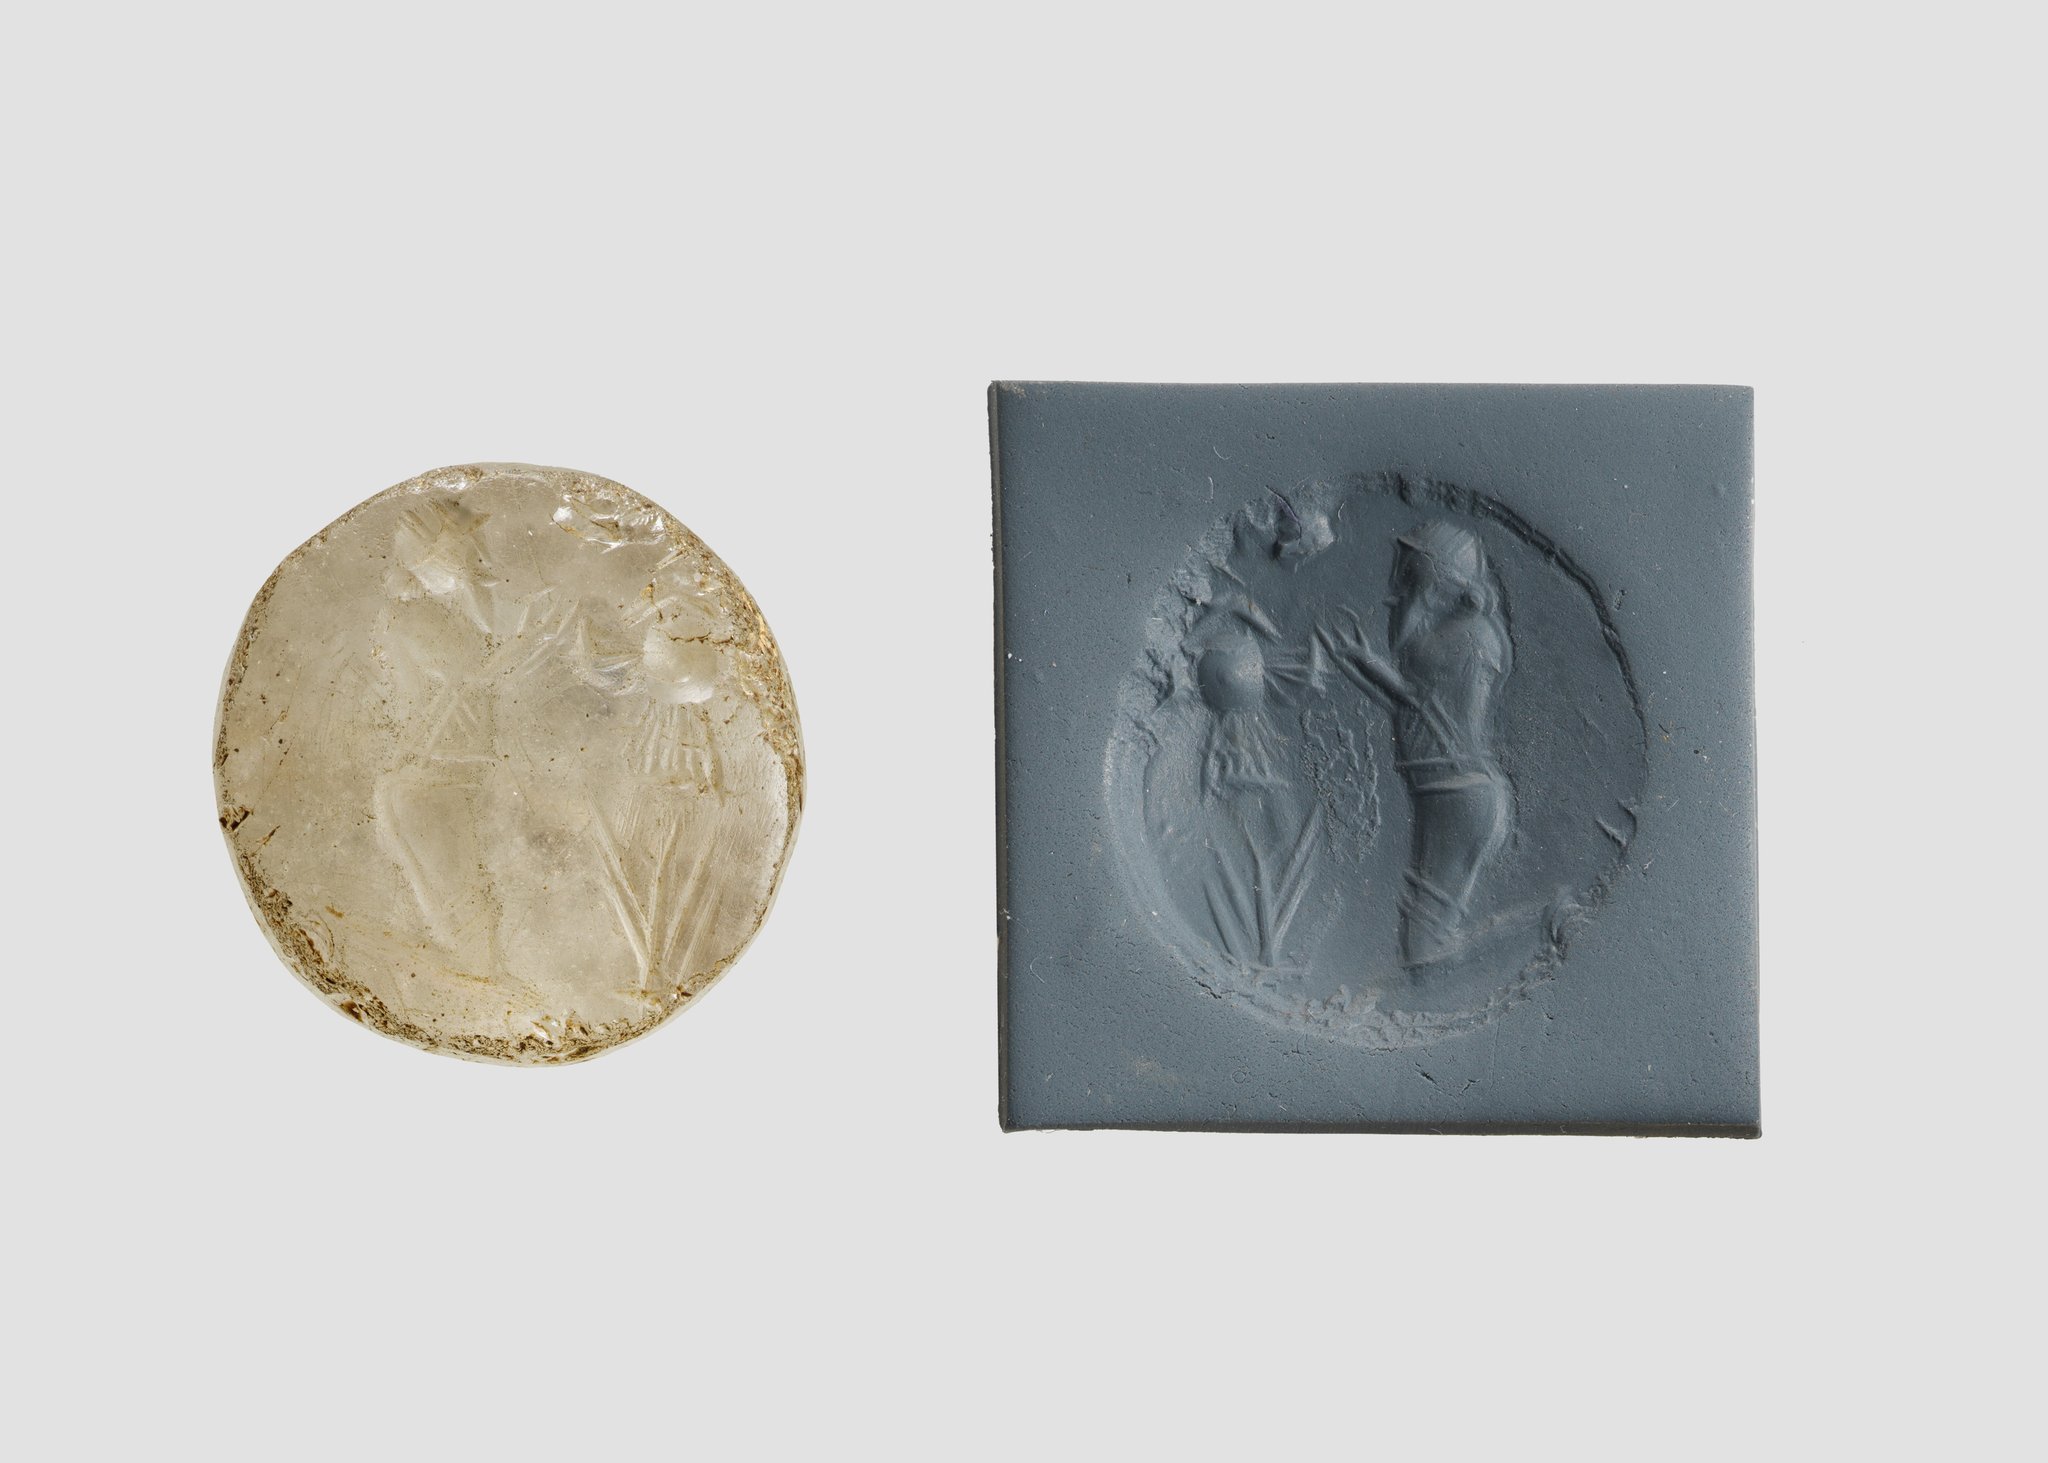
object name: stamp seal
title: Conoid seal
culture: stamp seal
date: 700-601 BCE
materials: quartz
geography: mesopotamia